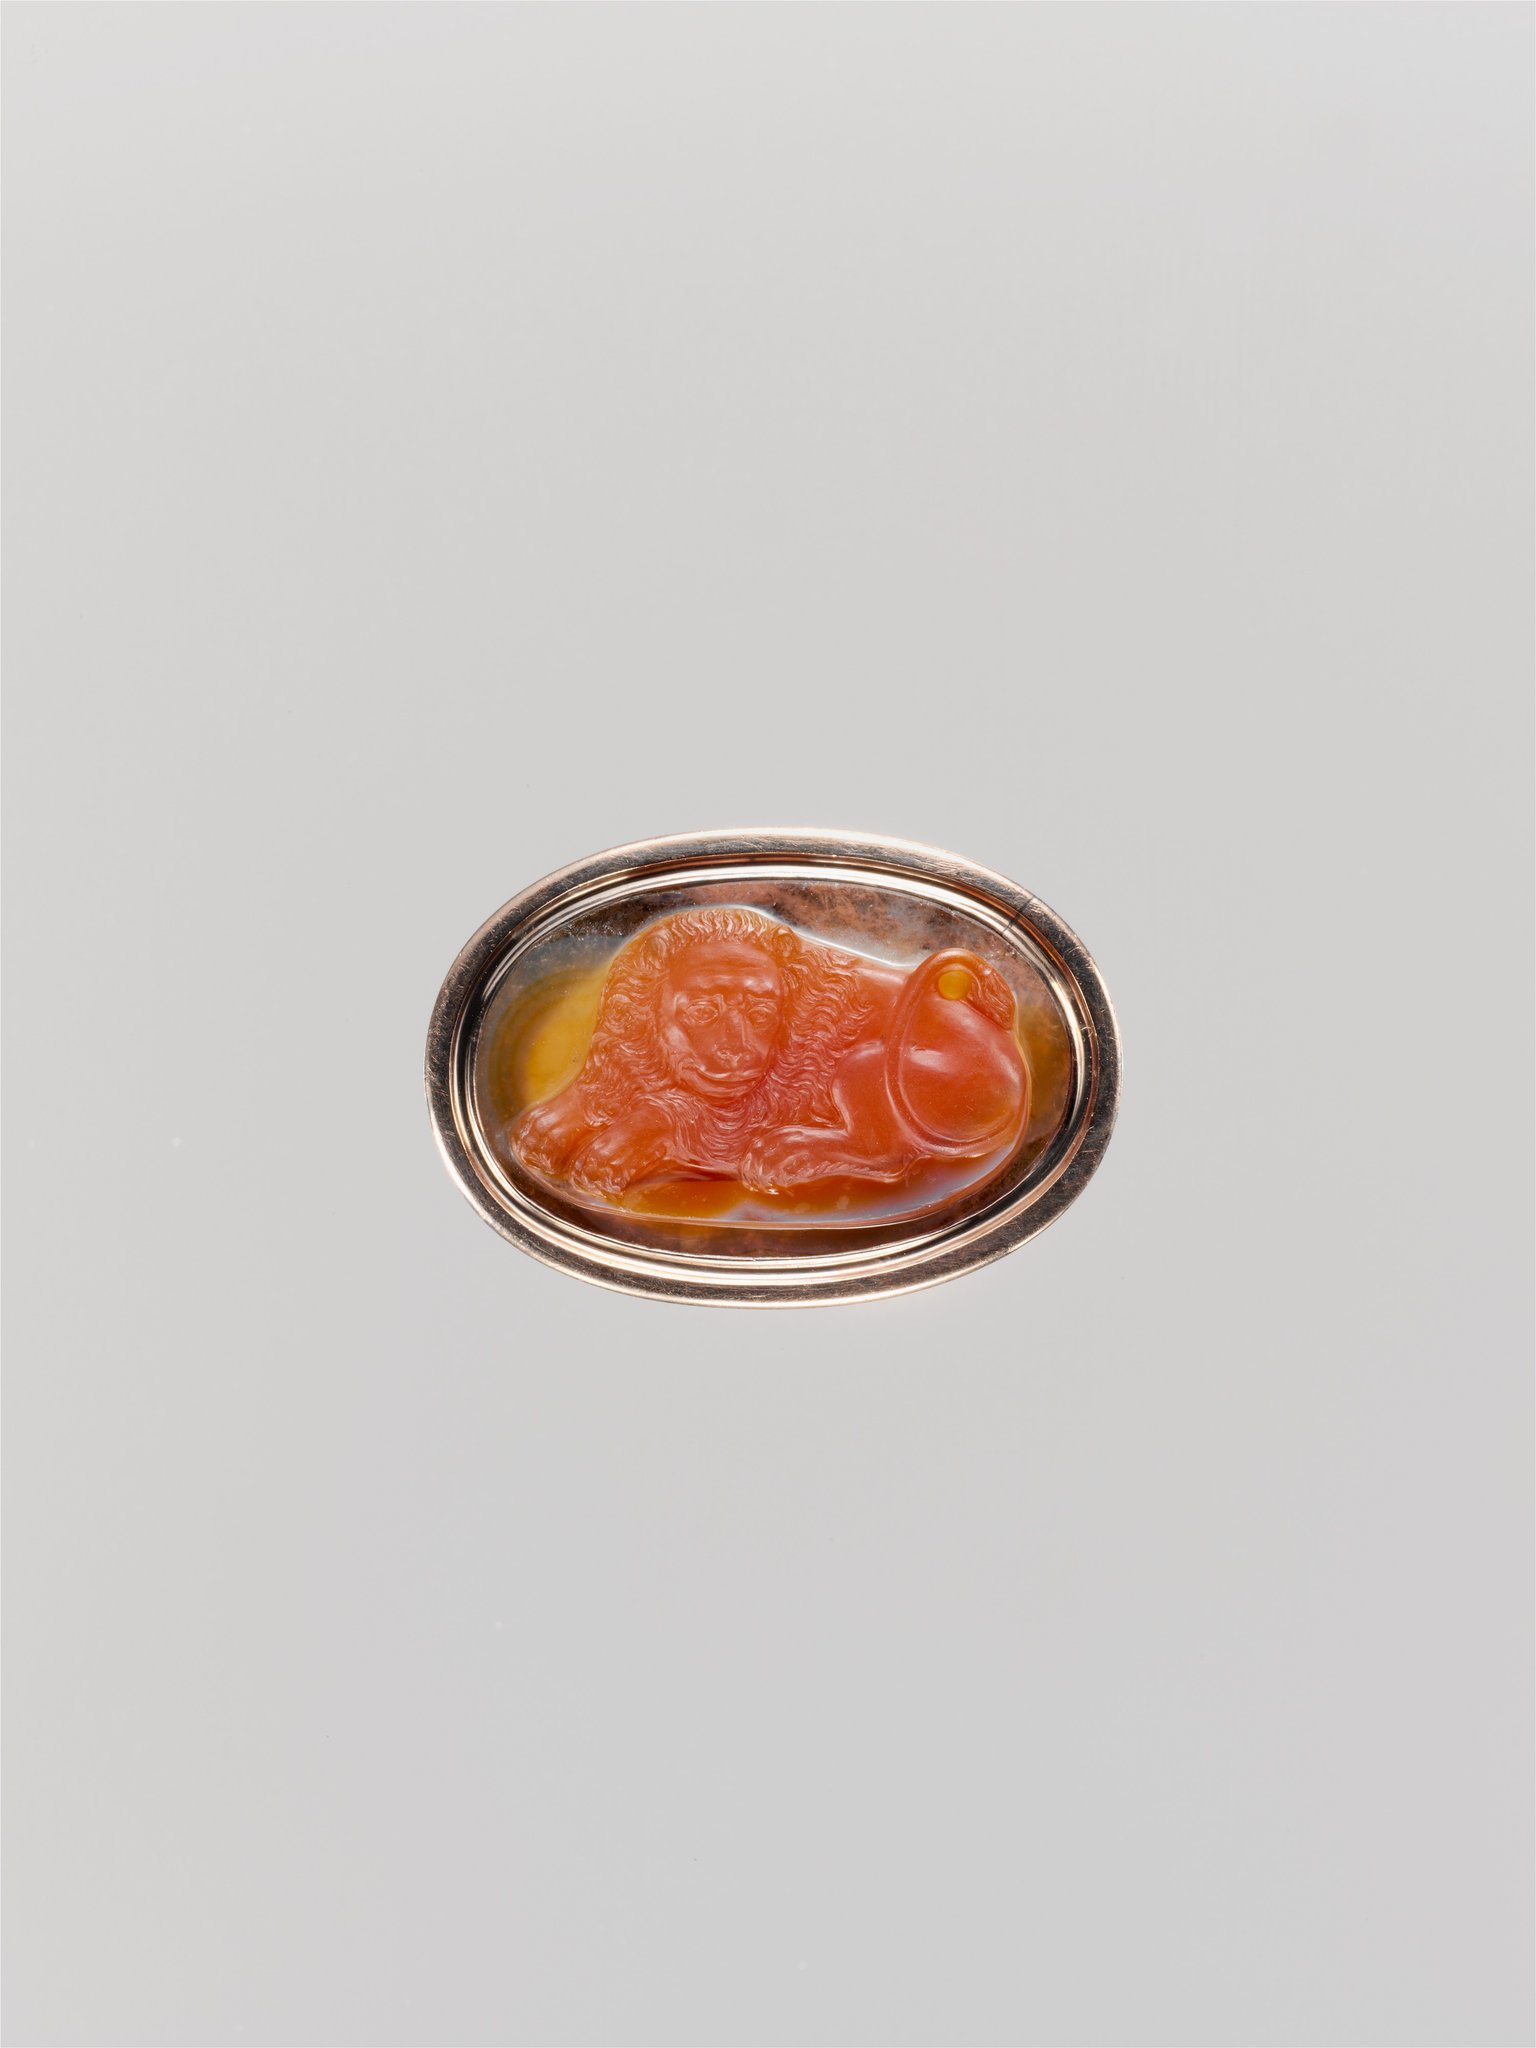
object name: cameo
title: Recumbent lion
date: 1701-1900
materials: gold, gemstone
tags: lions